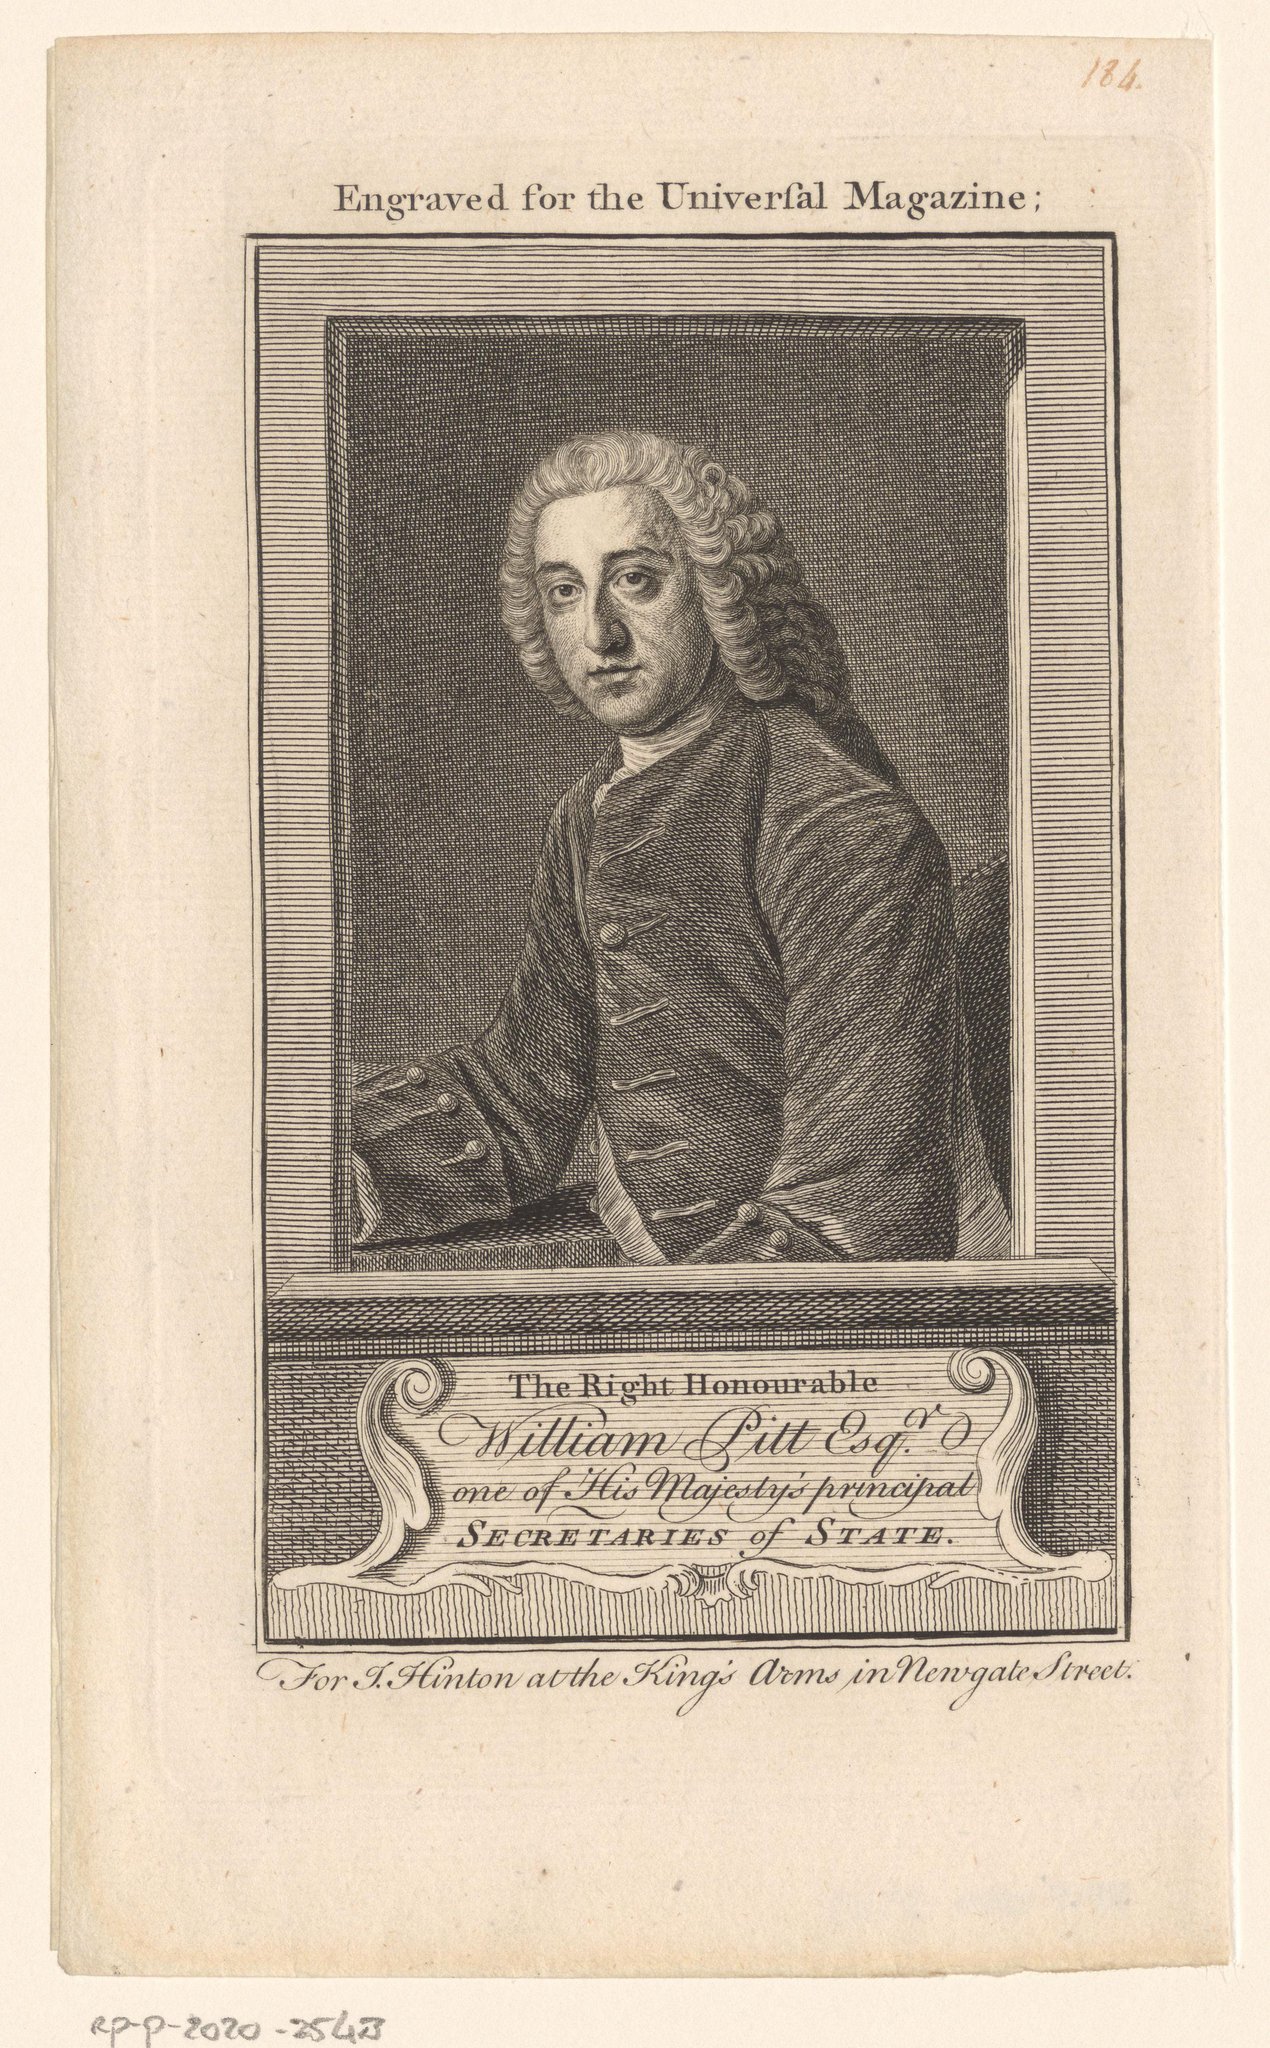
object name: print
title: Portret van William Pitt I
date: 1747-1781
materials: paper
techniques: engraving, etching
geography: london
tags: william pitt (i), historical persons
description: Prent uit: The Universal Magazine of Knowledge and Pleasure, 1747-1814.